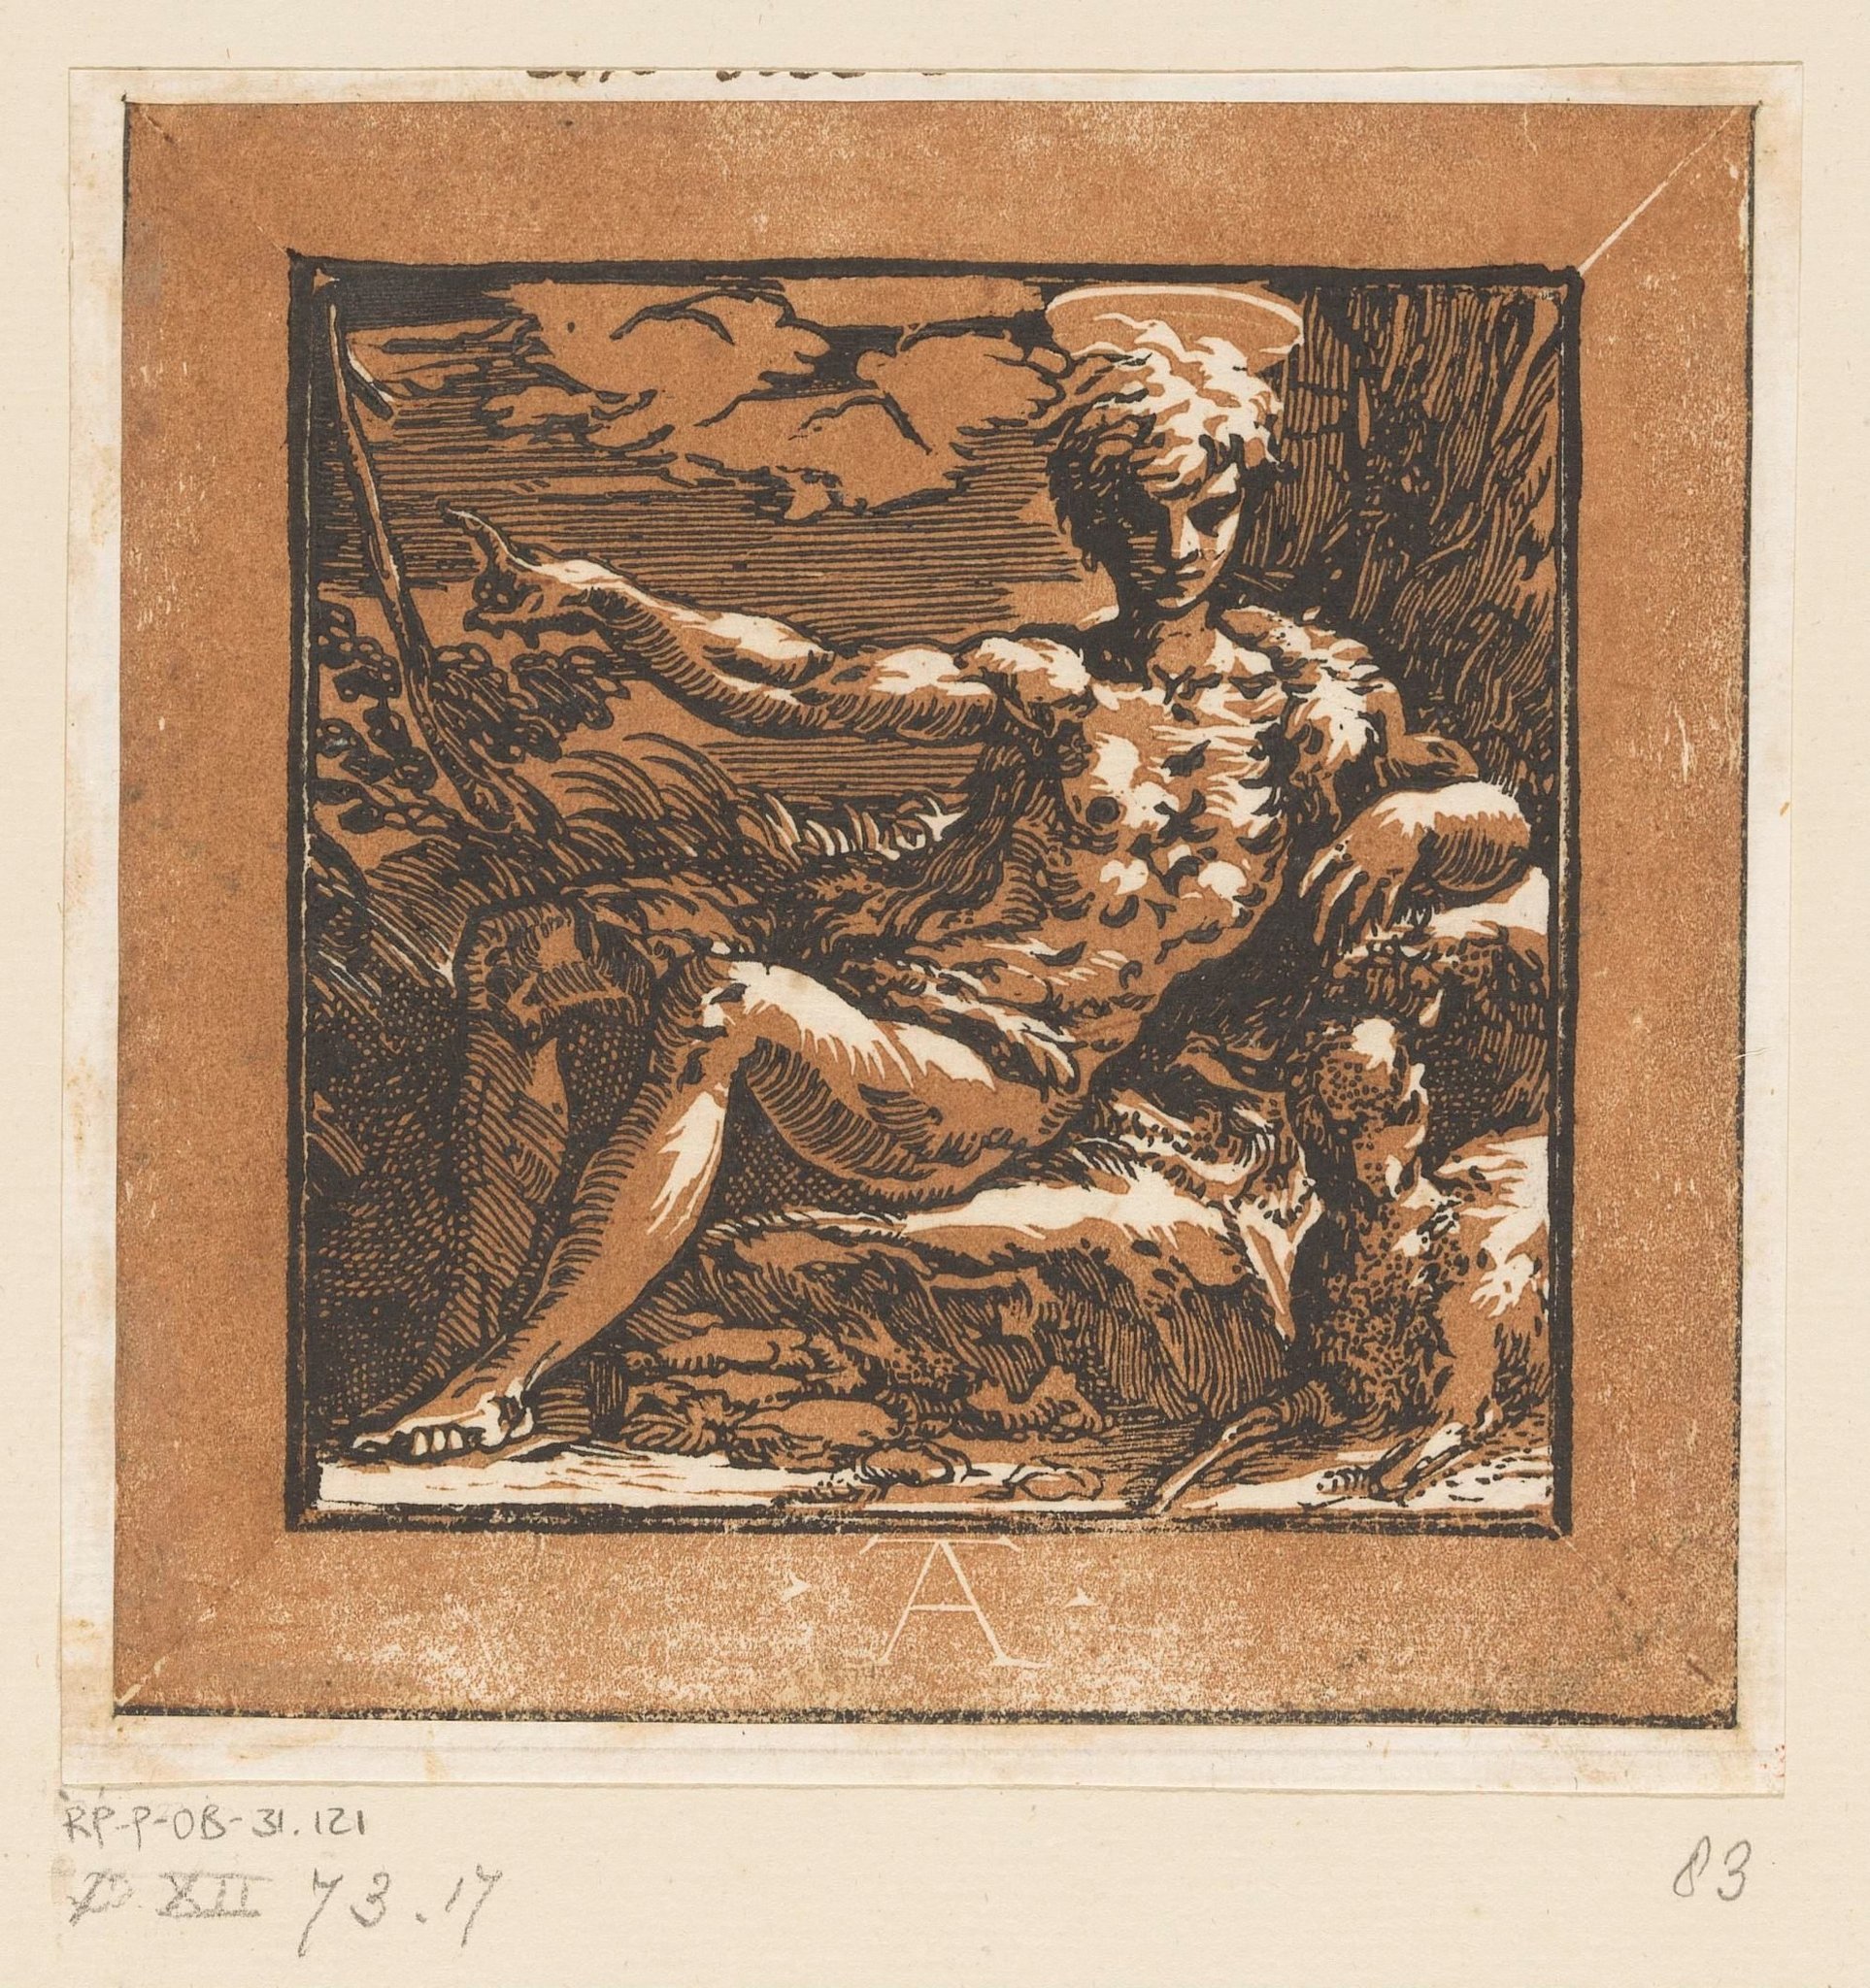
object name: print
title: Johannes de Doper in de wildernis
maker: antonio da trento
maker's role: painter, print maker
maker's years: 1510-1550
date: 1520-1550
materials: paper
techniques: woodcut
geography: italy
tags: john the baptist; possible attributes: book, reed cross, baptismal cup, honeycomb, lamb, staff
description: Johannes de Doper met lam en rieten kruis.